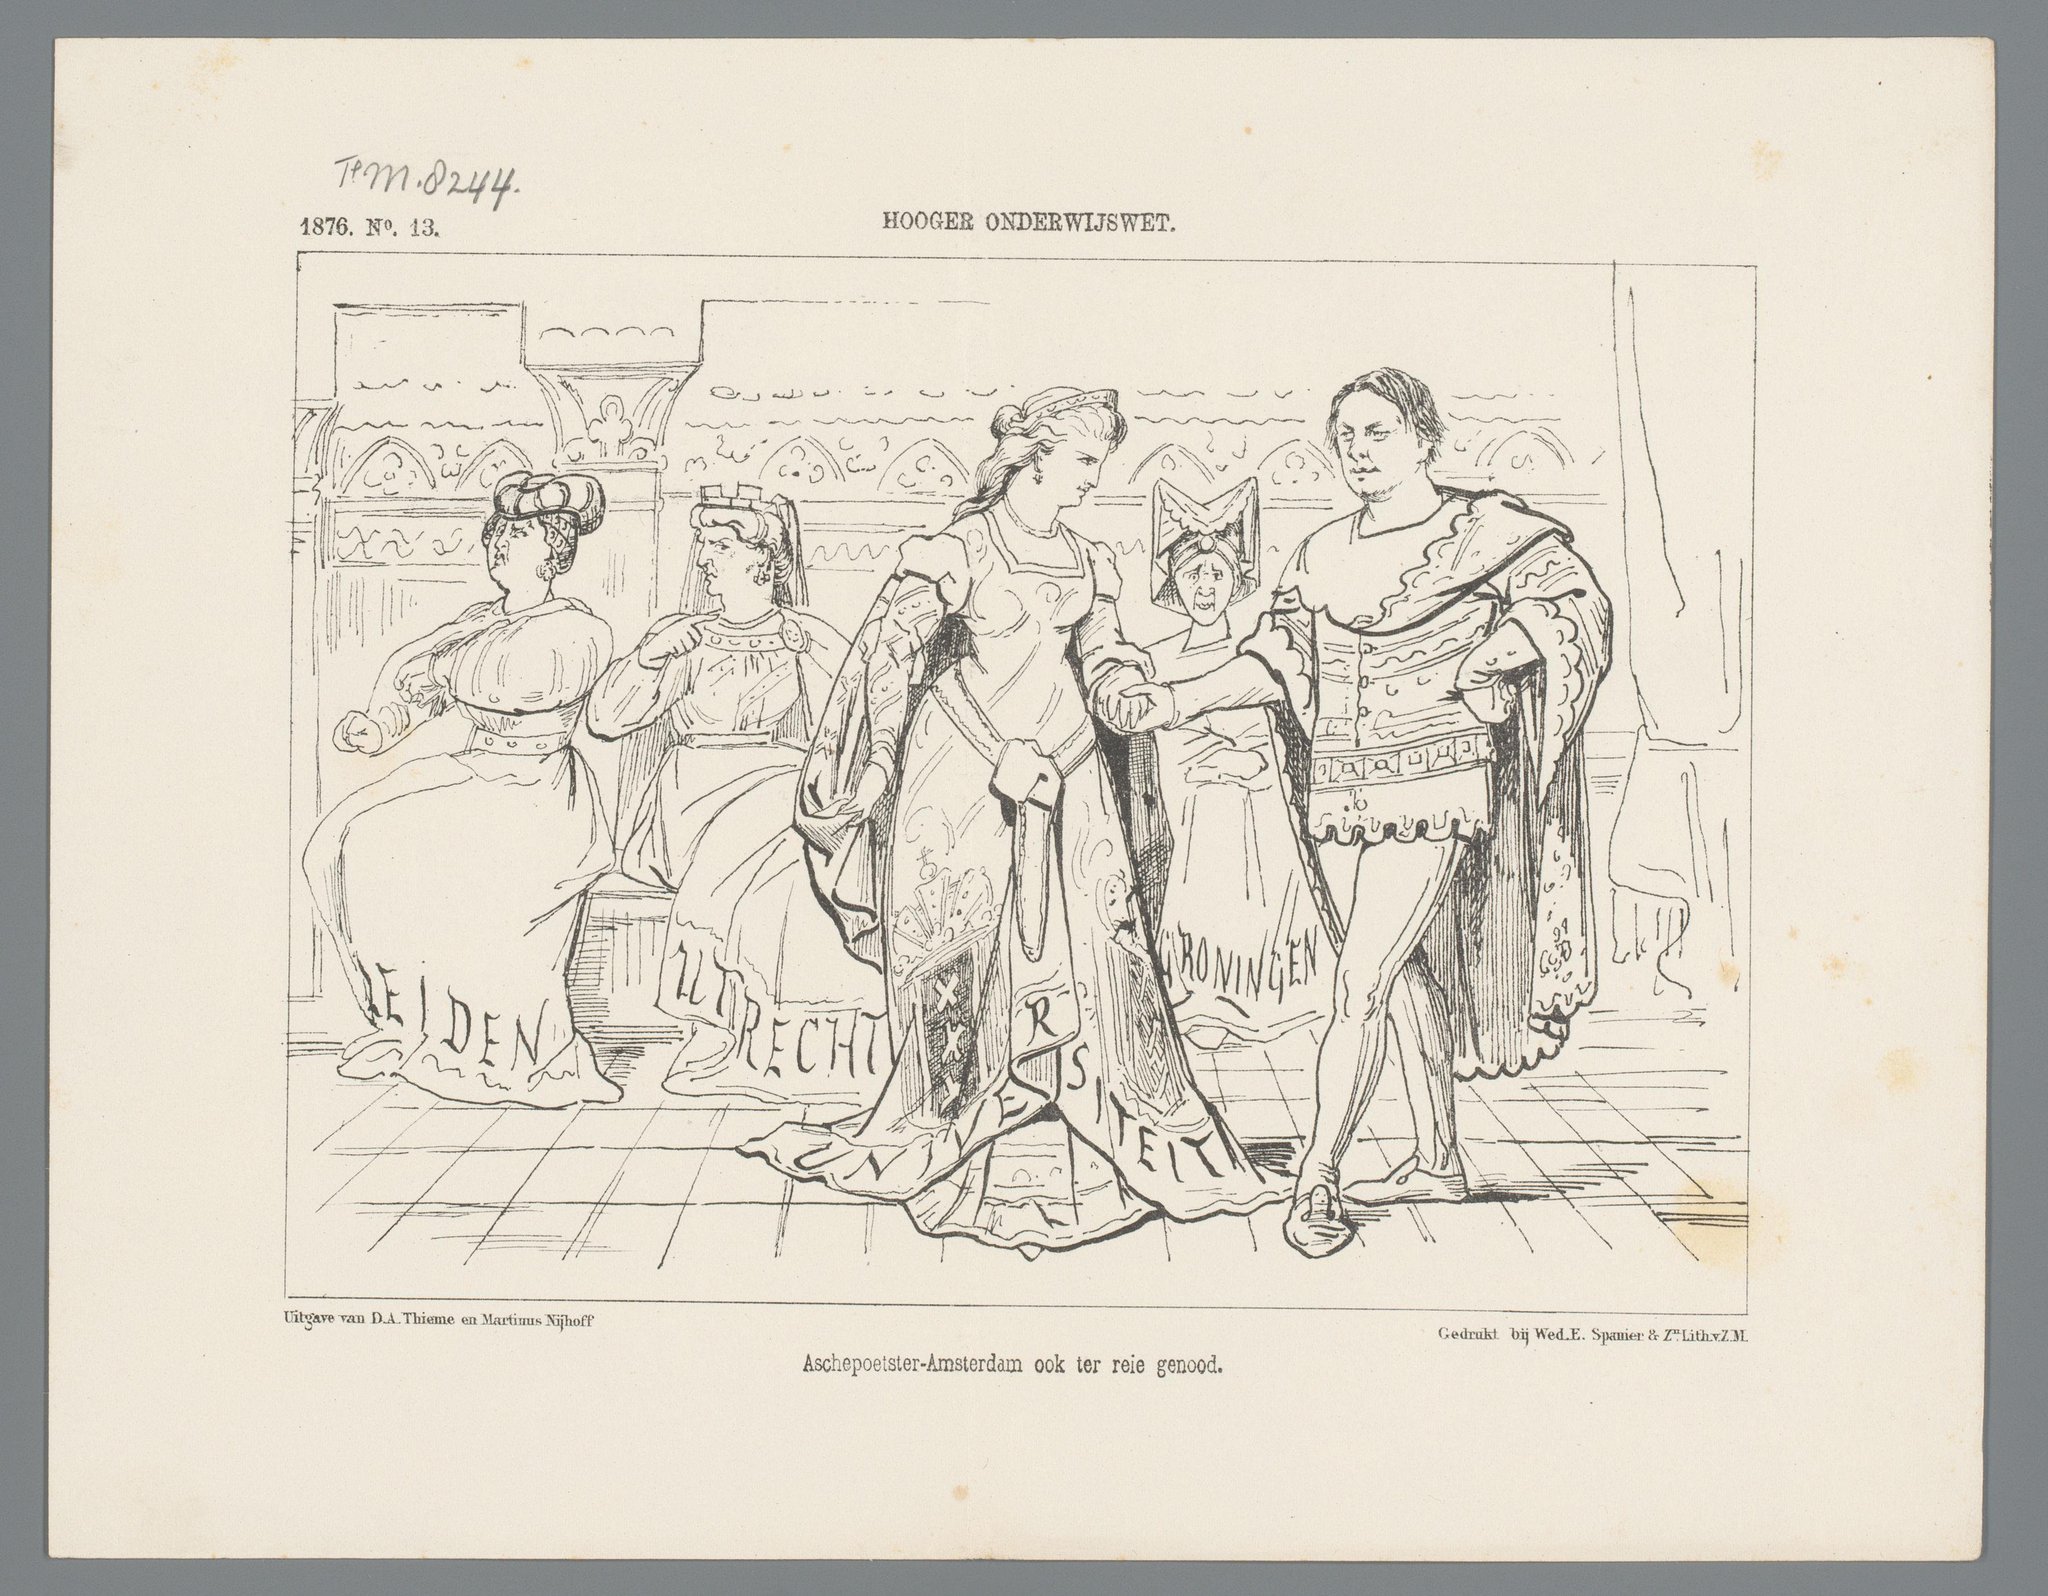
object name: print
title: Spotprent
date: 1876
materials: paper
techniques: lithograph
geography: the hague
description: Spotprent . Plaat verschenen bij het weekblad De Nederlandsche Spectator, nr. 13, 1876.